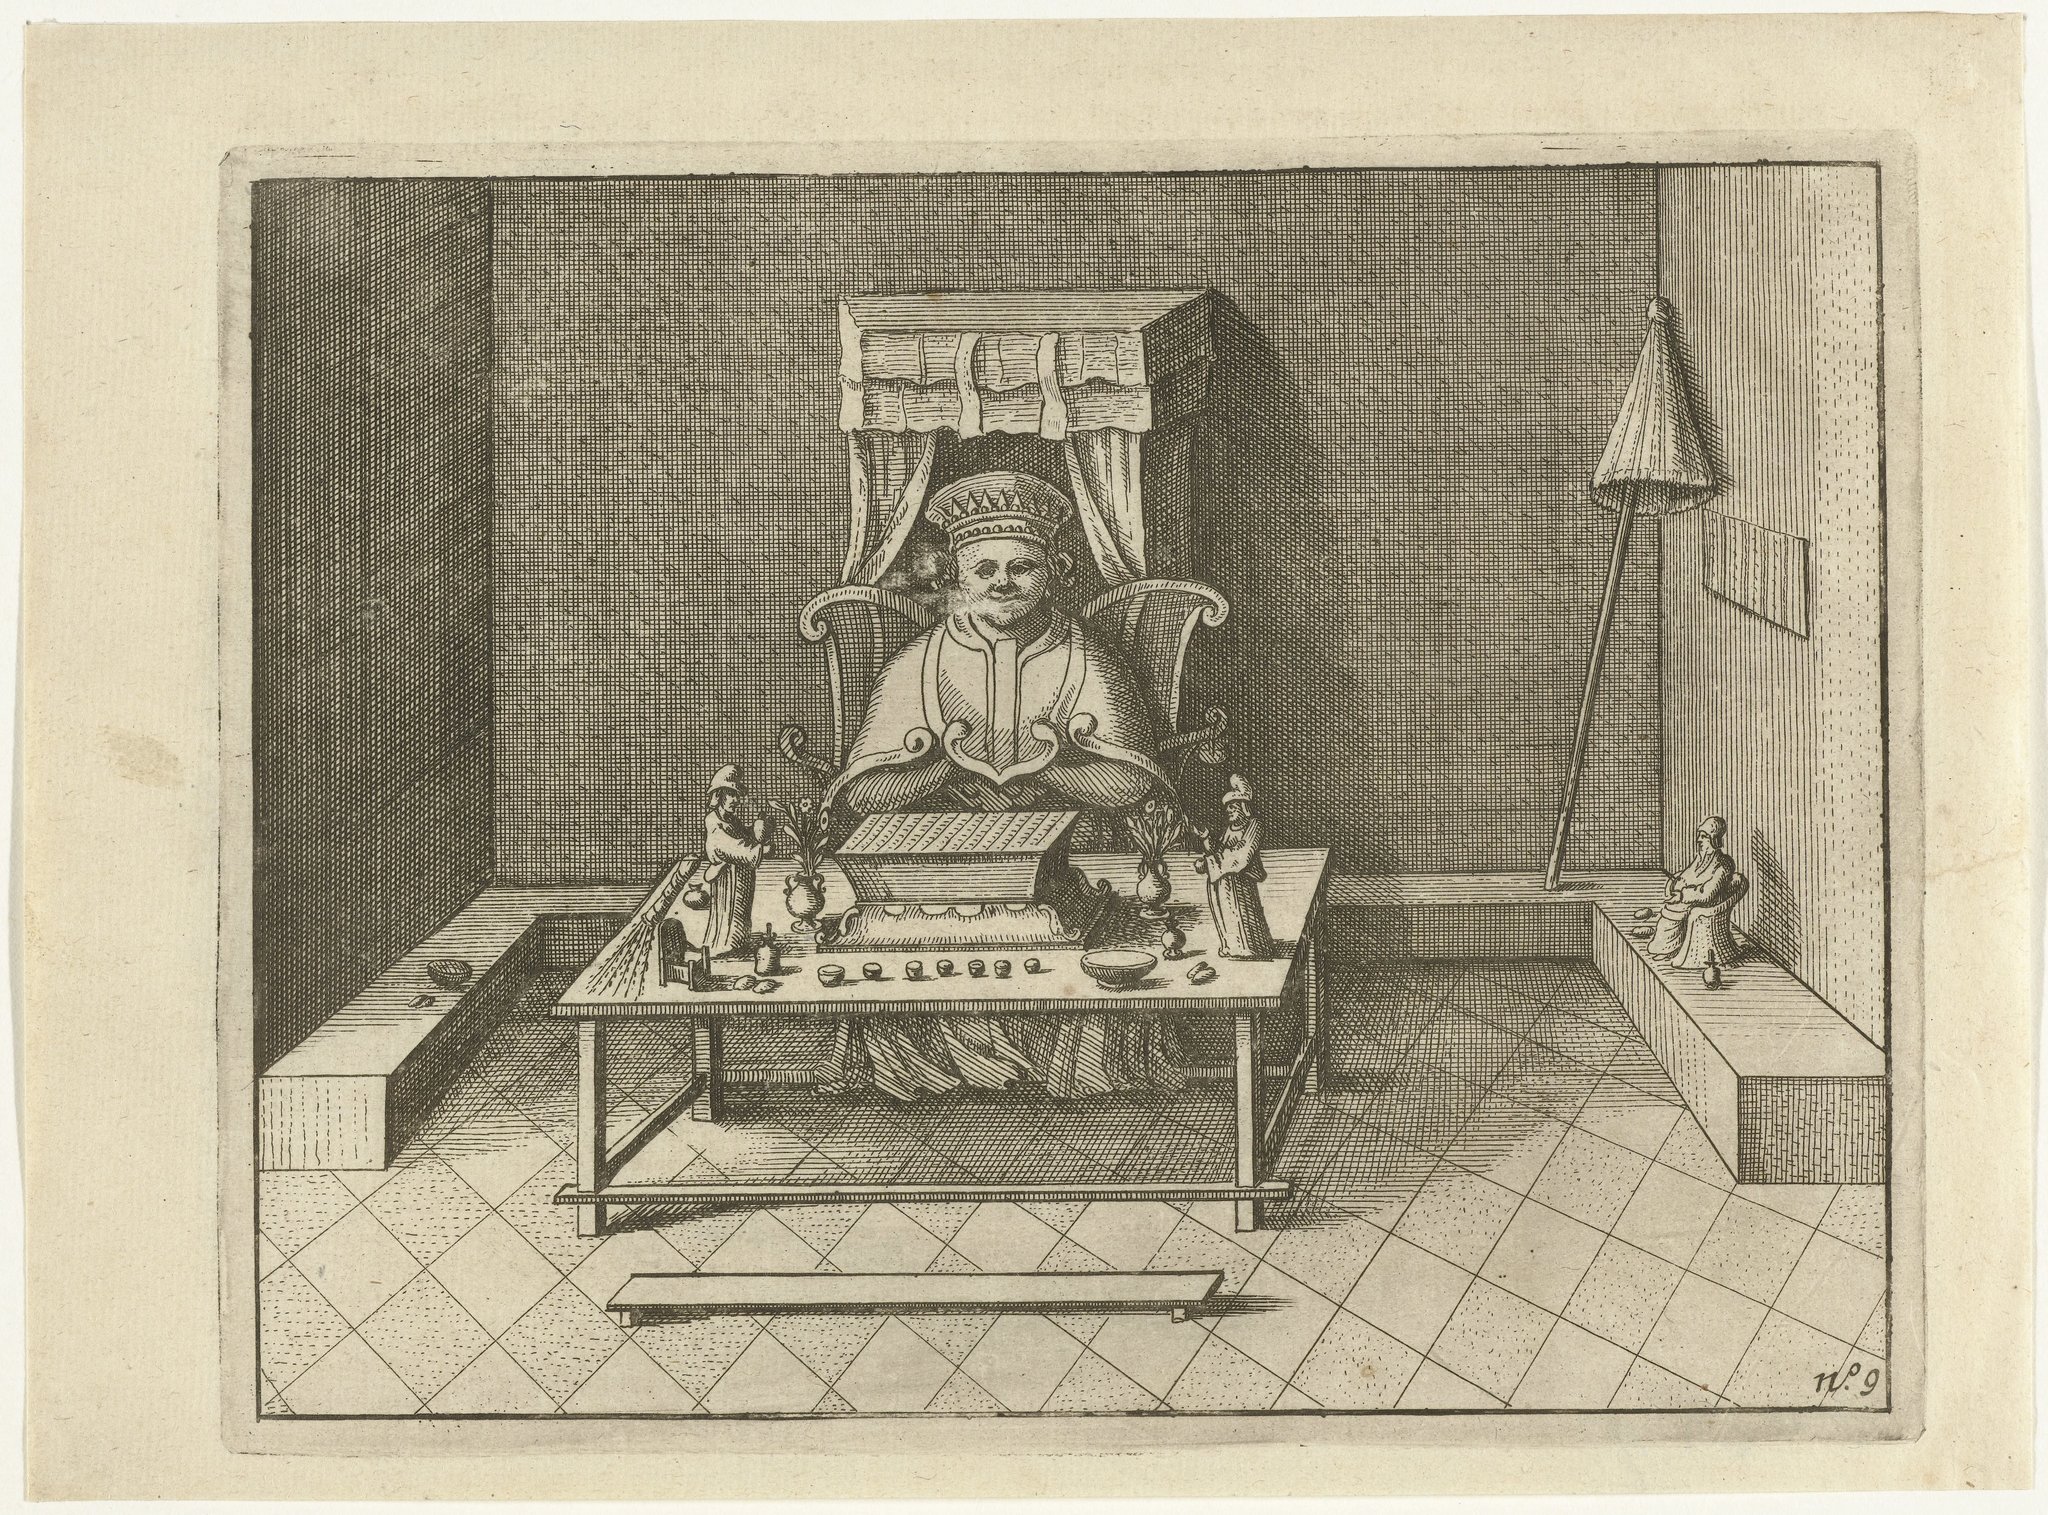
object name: print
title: Chinese goddess in a temple on Nan'ao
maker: Anonymous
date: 1644-1646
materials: paper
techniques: etching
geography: northern netherlands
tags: mayor, statues, paintings, etc. ~ objects of worship (traditional chinese religions), altar ~ traditional chinese religions, landscapes in tropical and sub-tropical regions, exploration, expedition, voyage of discovery, china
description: Gebruikt als illustratie: Historisch Verhael Vande treffelijcke Reyse, gedaen naer de Oost-Indien ende China, met elf Schepen. Door den Manhaften Admirael Cornelis Matelief de Jonge. Inden Jaren 1605. 1606. 1607. ende 1608. Deze tekst opgenomen in : I. Commelin, Begin ende voortgangh, van de Vereenighde Nederlantsche Geoctroyeerde Oost-Indische Compagnie, J. Janssonius, Amsterdam 1646. Genummerd: No. 9.